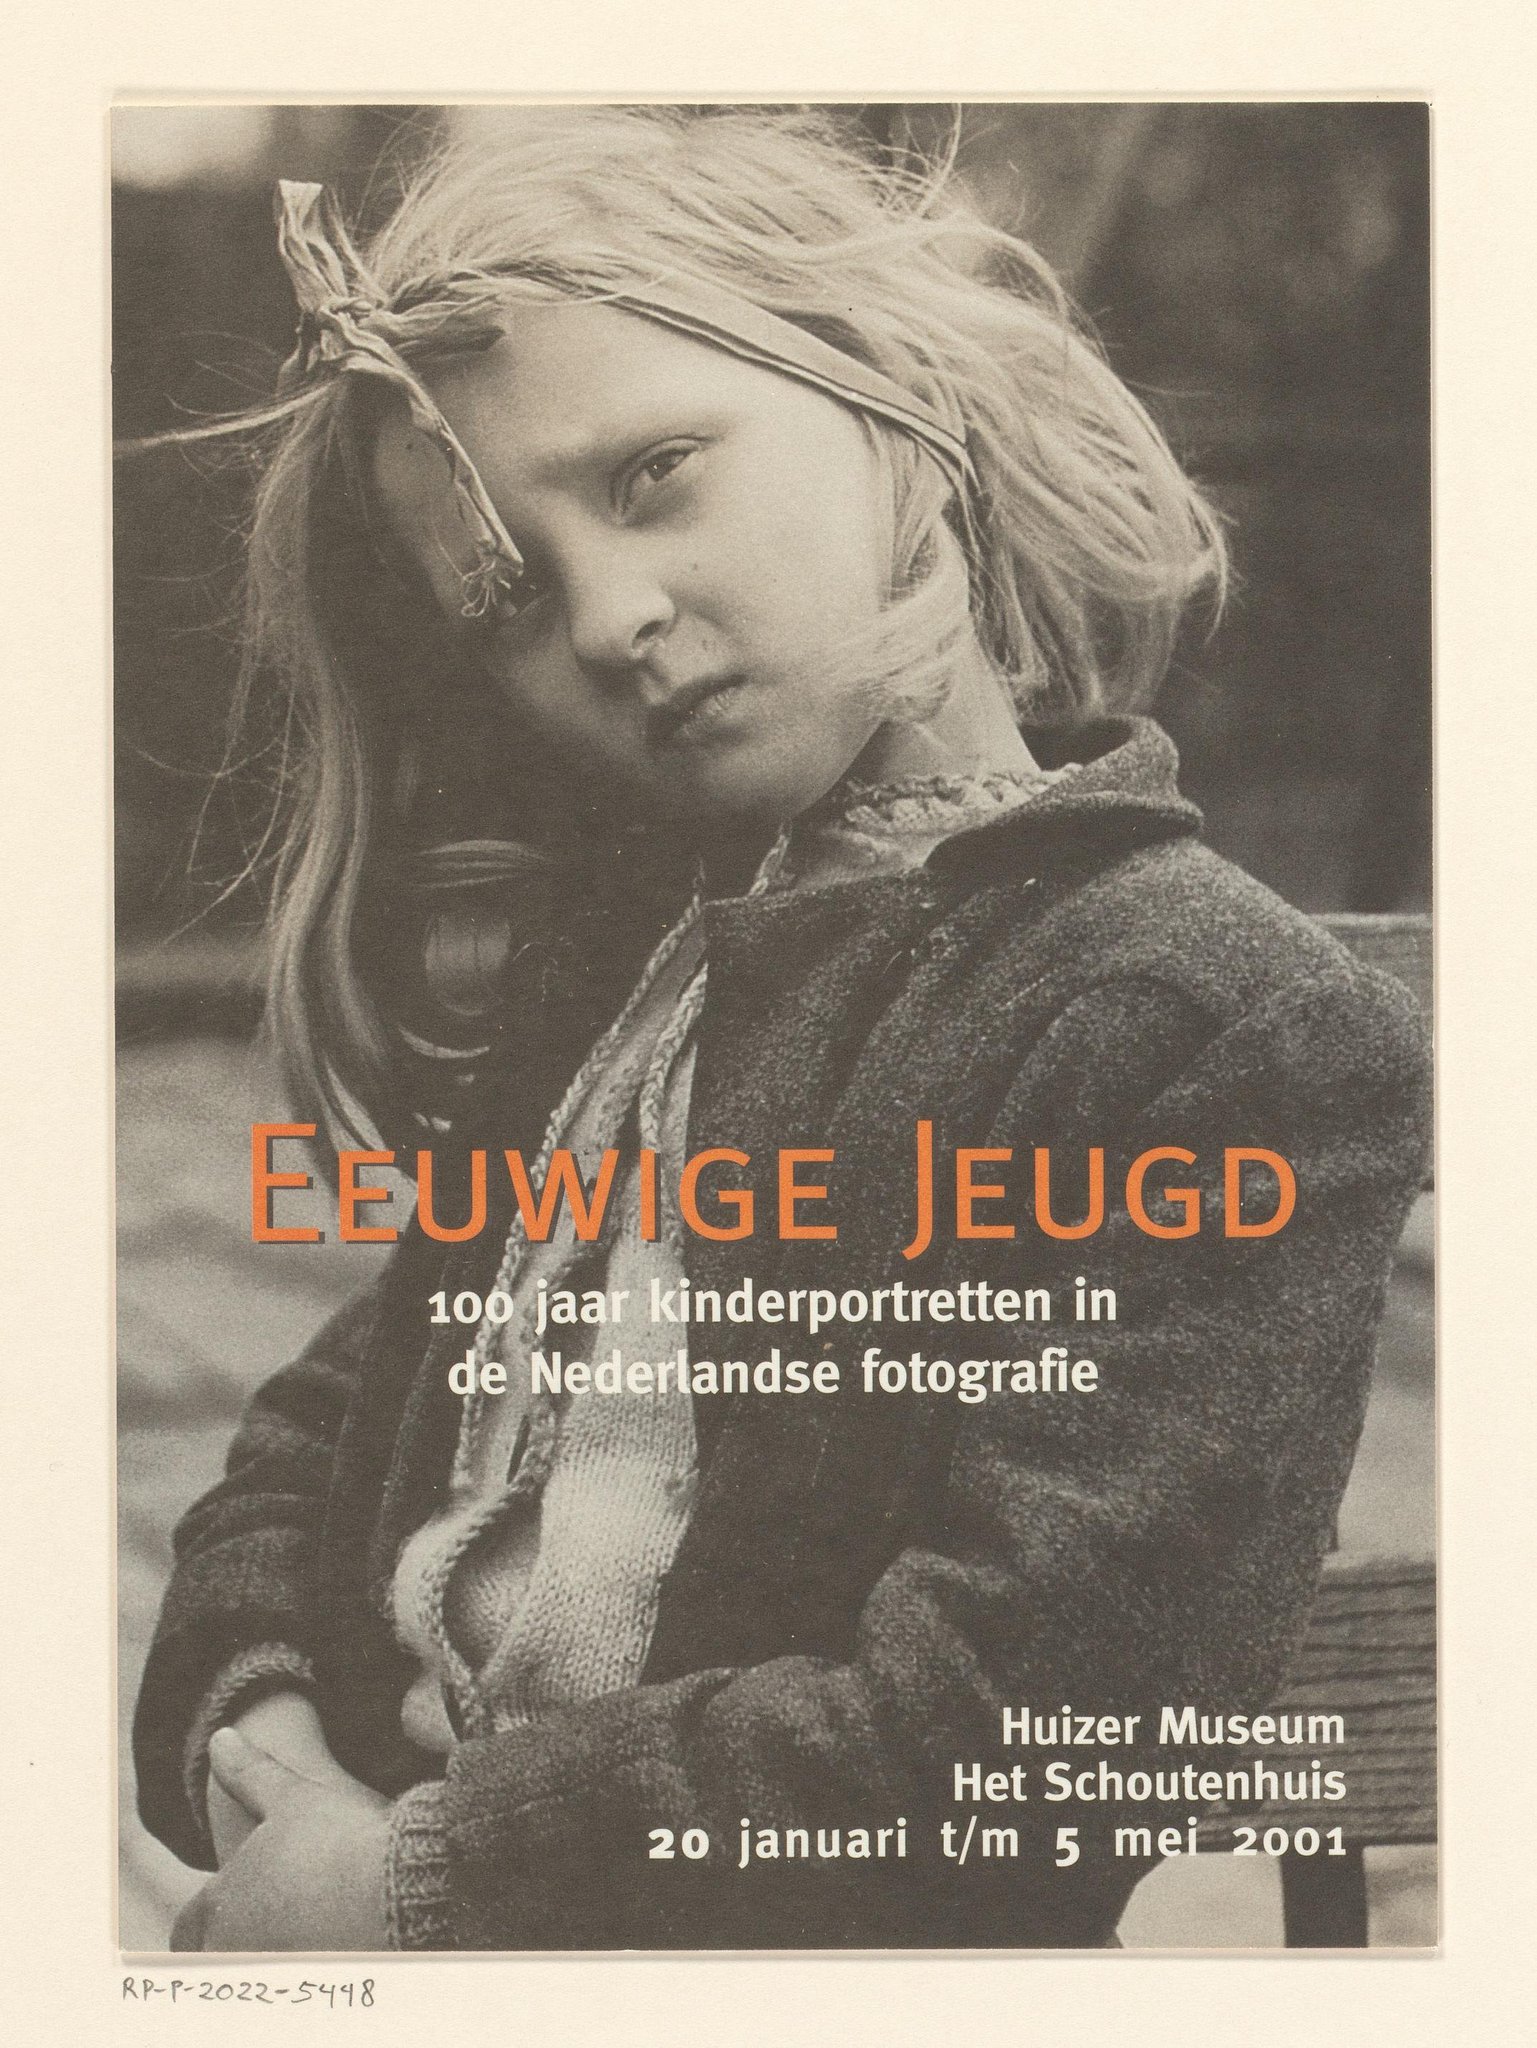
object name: fotomechanisch procedé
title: Uitnodiging van het Huizer Museum voor de opening van de tentoonstelling: Eeuwige Jeugd, januari 2001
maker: emmy eugenie andriesse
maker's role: fotograaf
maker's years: 1914-1953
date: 2001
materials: paper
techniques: offset printed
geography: huizen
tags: historical persons not known by name - bb - woman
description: Uitnodiging van het Huizer Museum voor de opening van de tentoonstelling: Eeuwige Jeugd, 100 jaar kinderportretten in de Nederlandse fotografie, op 20 januari 2001. Foto van een meisje door Emmy Andriesse.